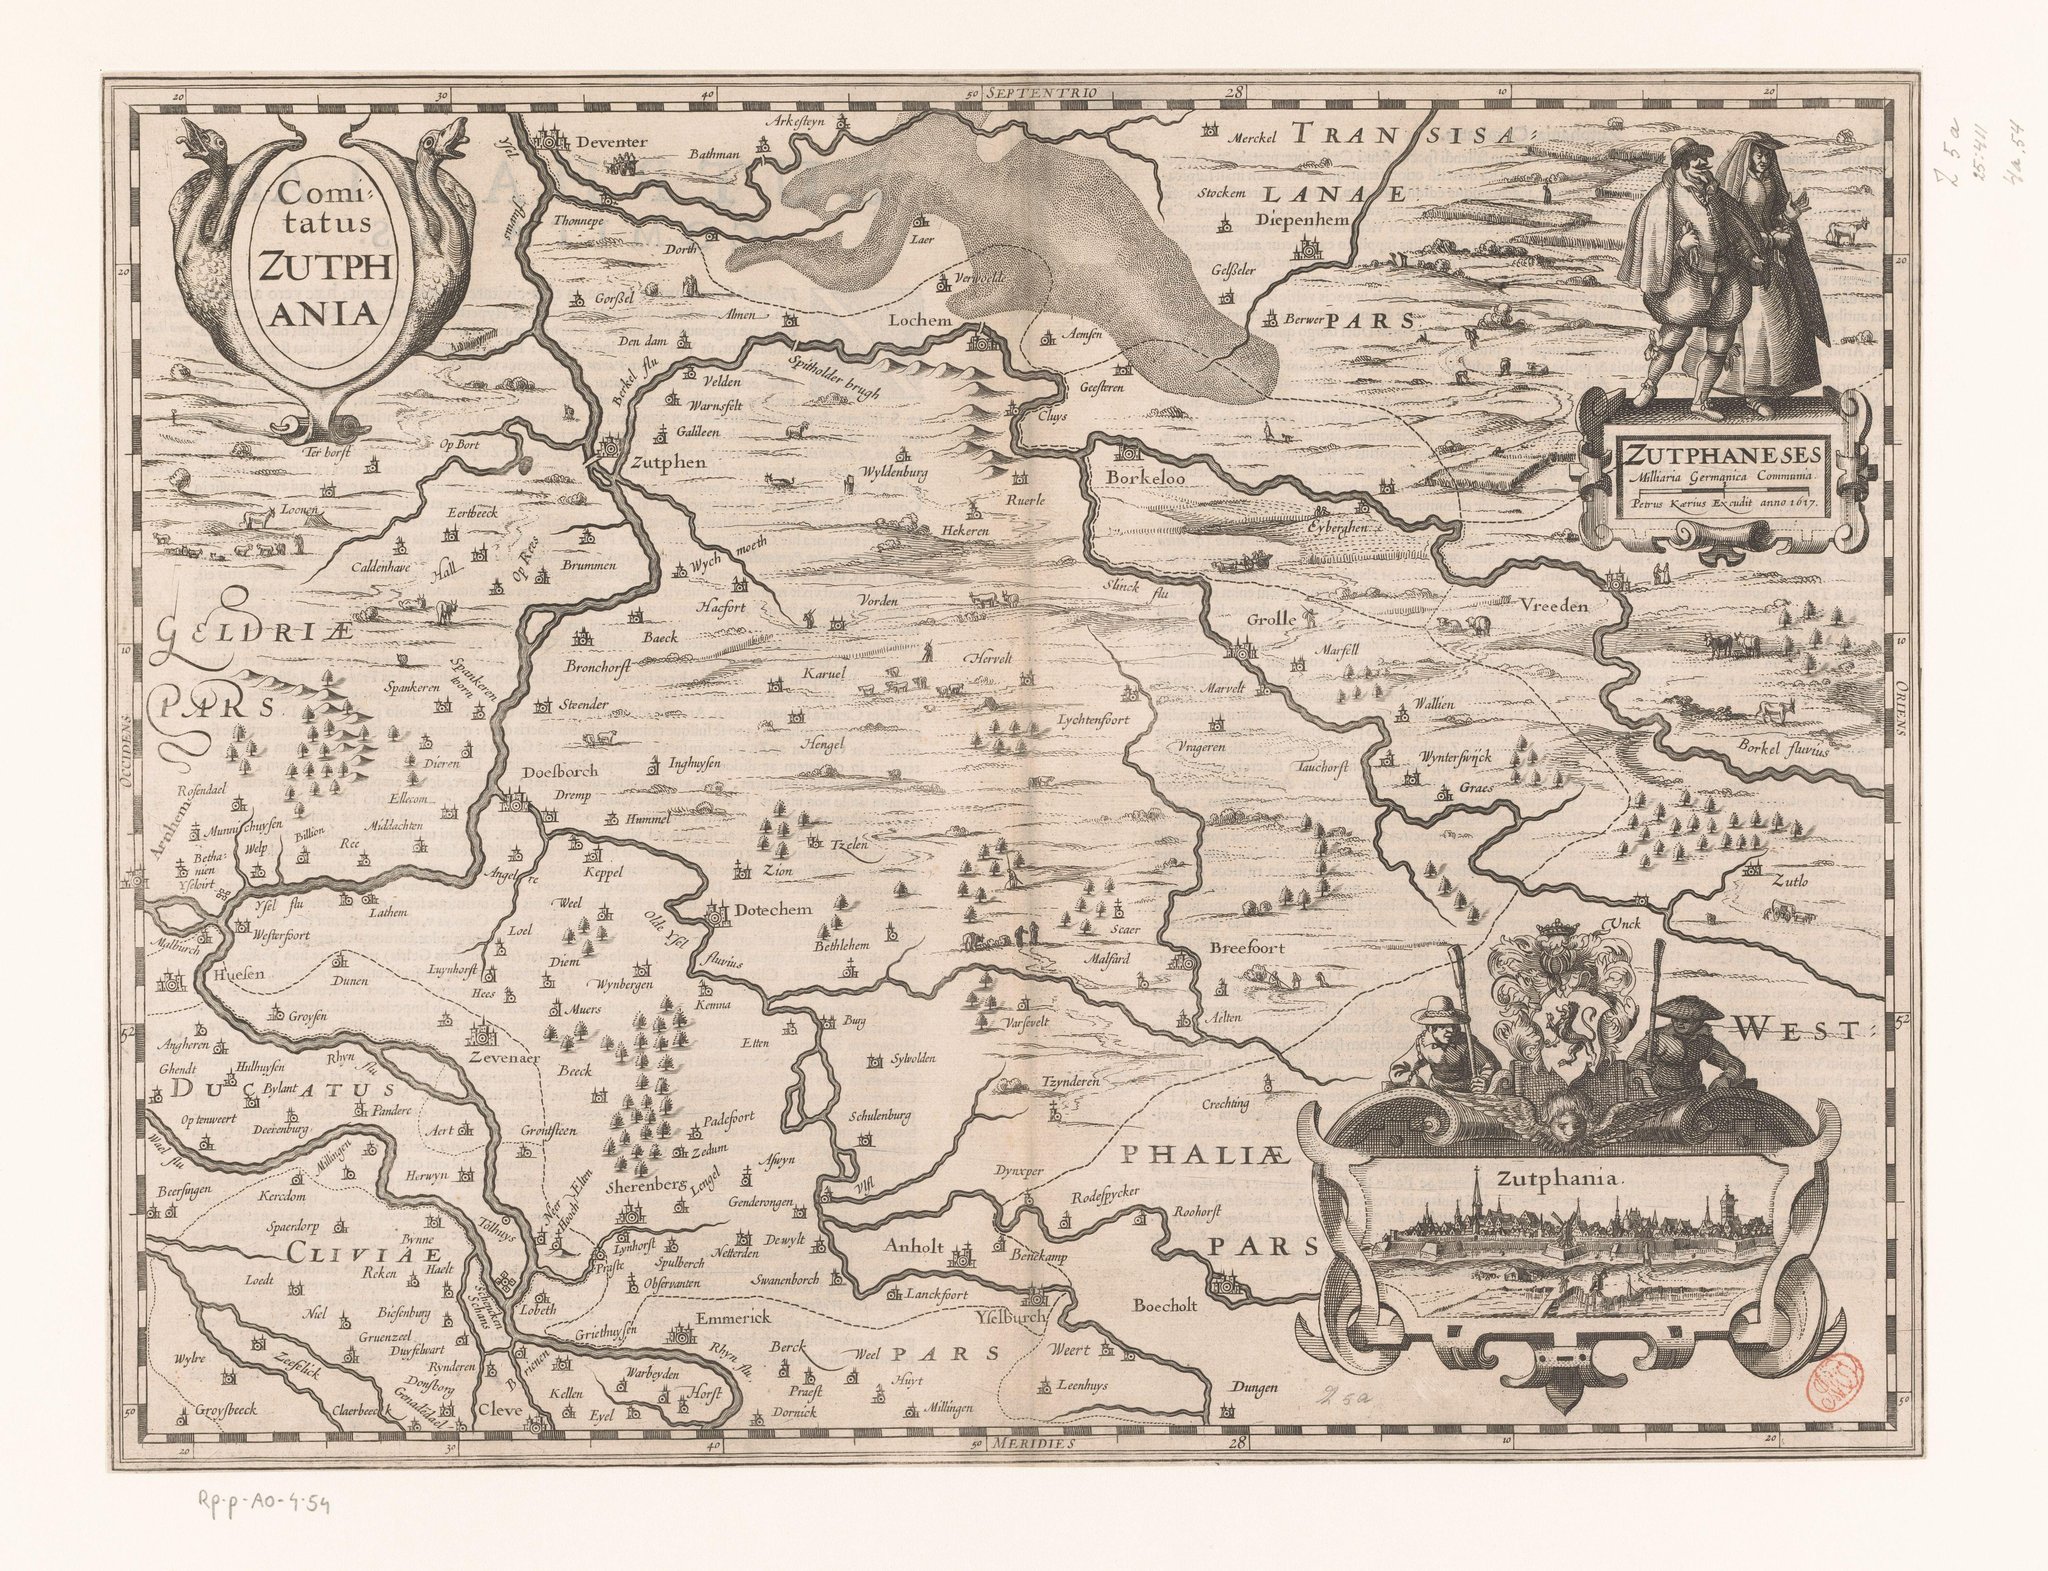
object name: print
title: Comitatus Zutphania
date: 1617-1622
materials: paper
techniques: engraving, etching, letterpress printing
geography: amsterdam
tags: maps of separate countries or regions, city-view in general; 'veduta', coat of arms (as symbol of the state, etc.) (+ province; provincial), gelderland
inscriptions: collector's mark: Lugt 195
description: Prent gebruikt in: Keere, Pieter van der. Germania inferior id est, provinciarum ejus novae et exactae tabulae geographicae. 1e druk. Amsterdam: Pieter van der Keere, 1617. Of in: Keere, Pieter van der. Germania inferior id est, provinciarum ejus novae et exactae tabulae geographicae. 2e druk. Amsterdam: Pieter van der Keere, 1622.